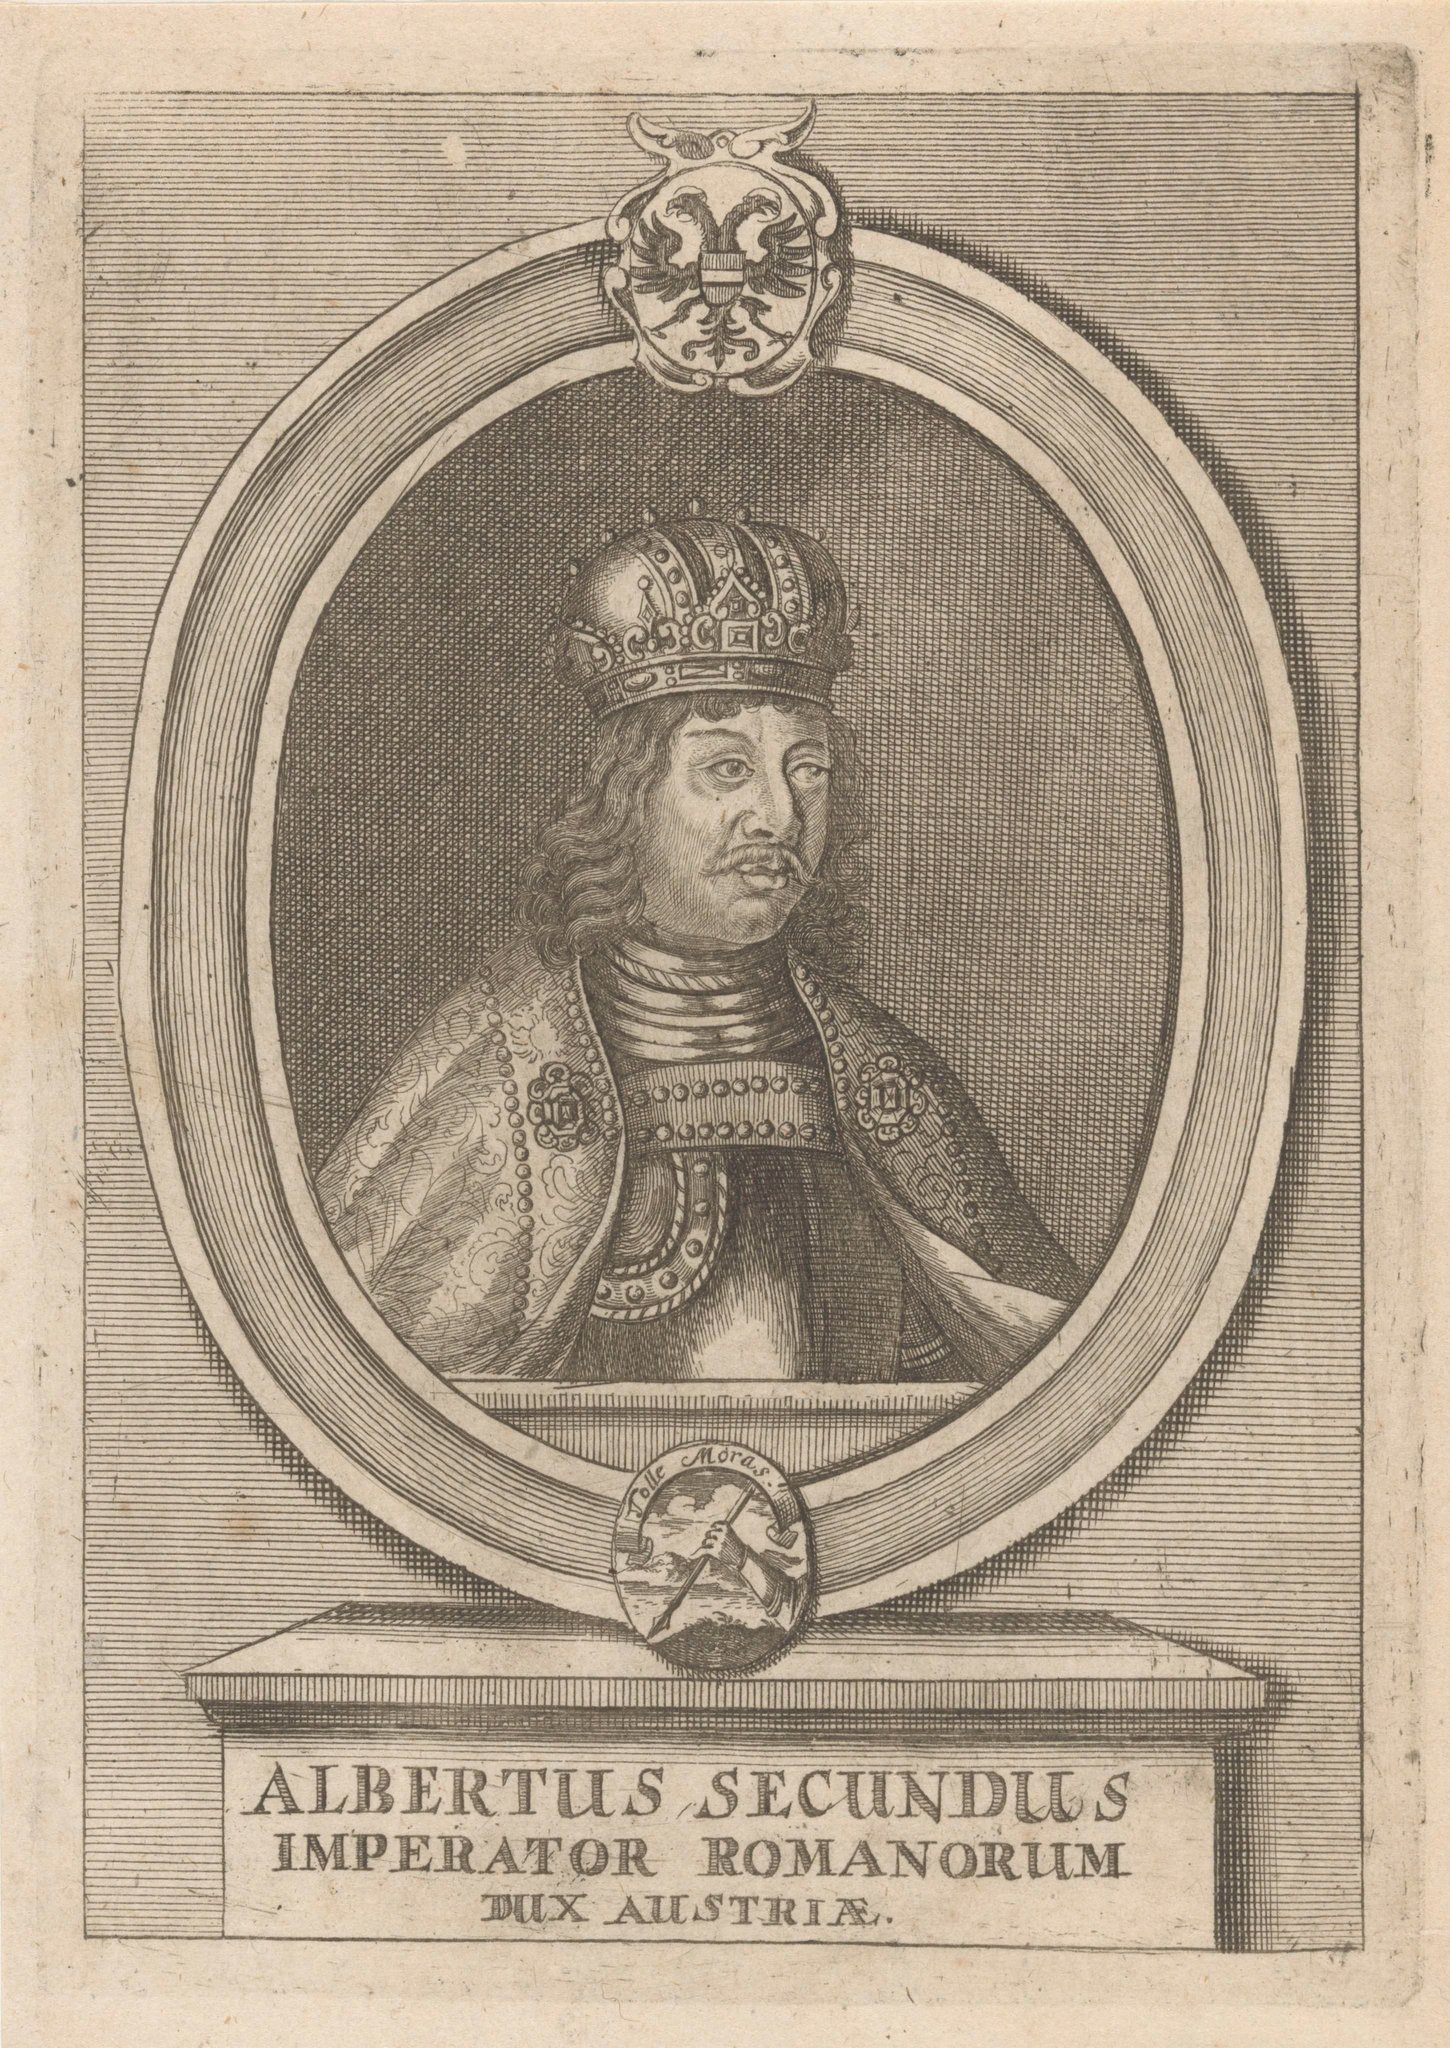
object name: print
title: Portret van Albrecht II van Habsburg, Rooms-Duits koning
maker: Anonymous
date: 1600-1699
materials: paper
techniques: engraving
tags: albrecht ii van habsburg (rooms-duits koning)